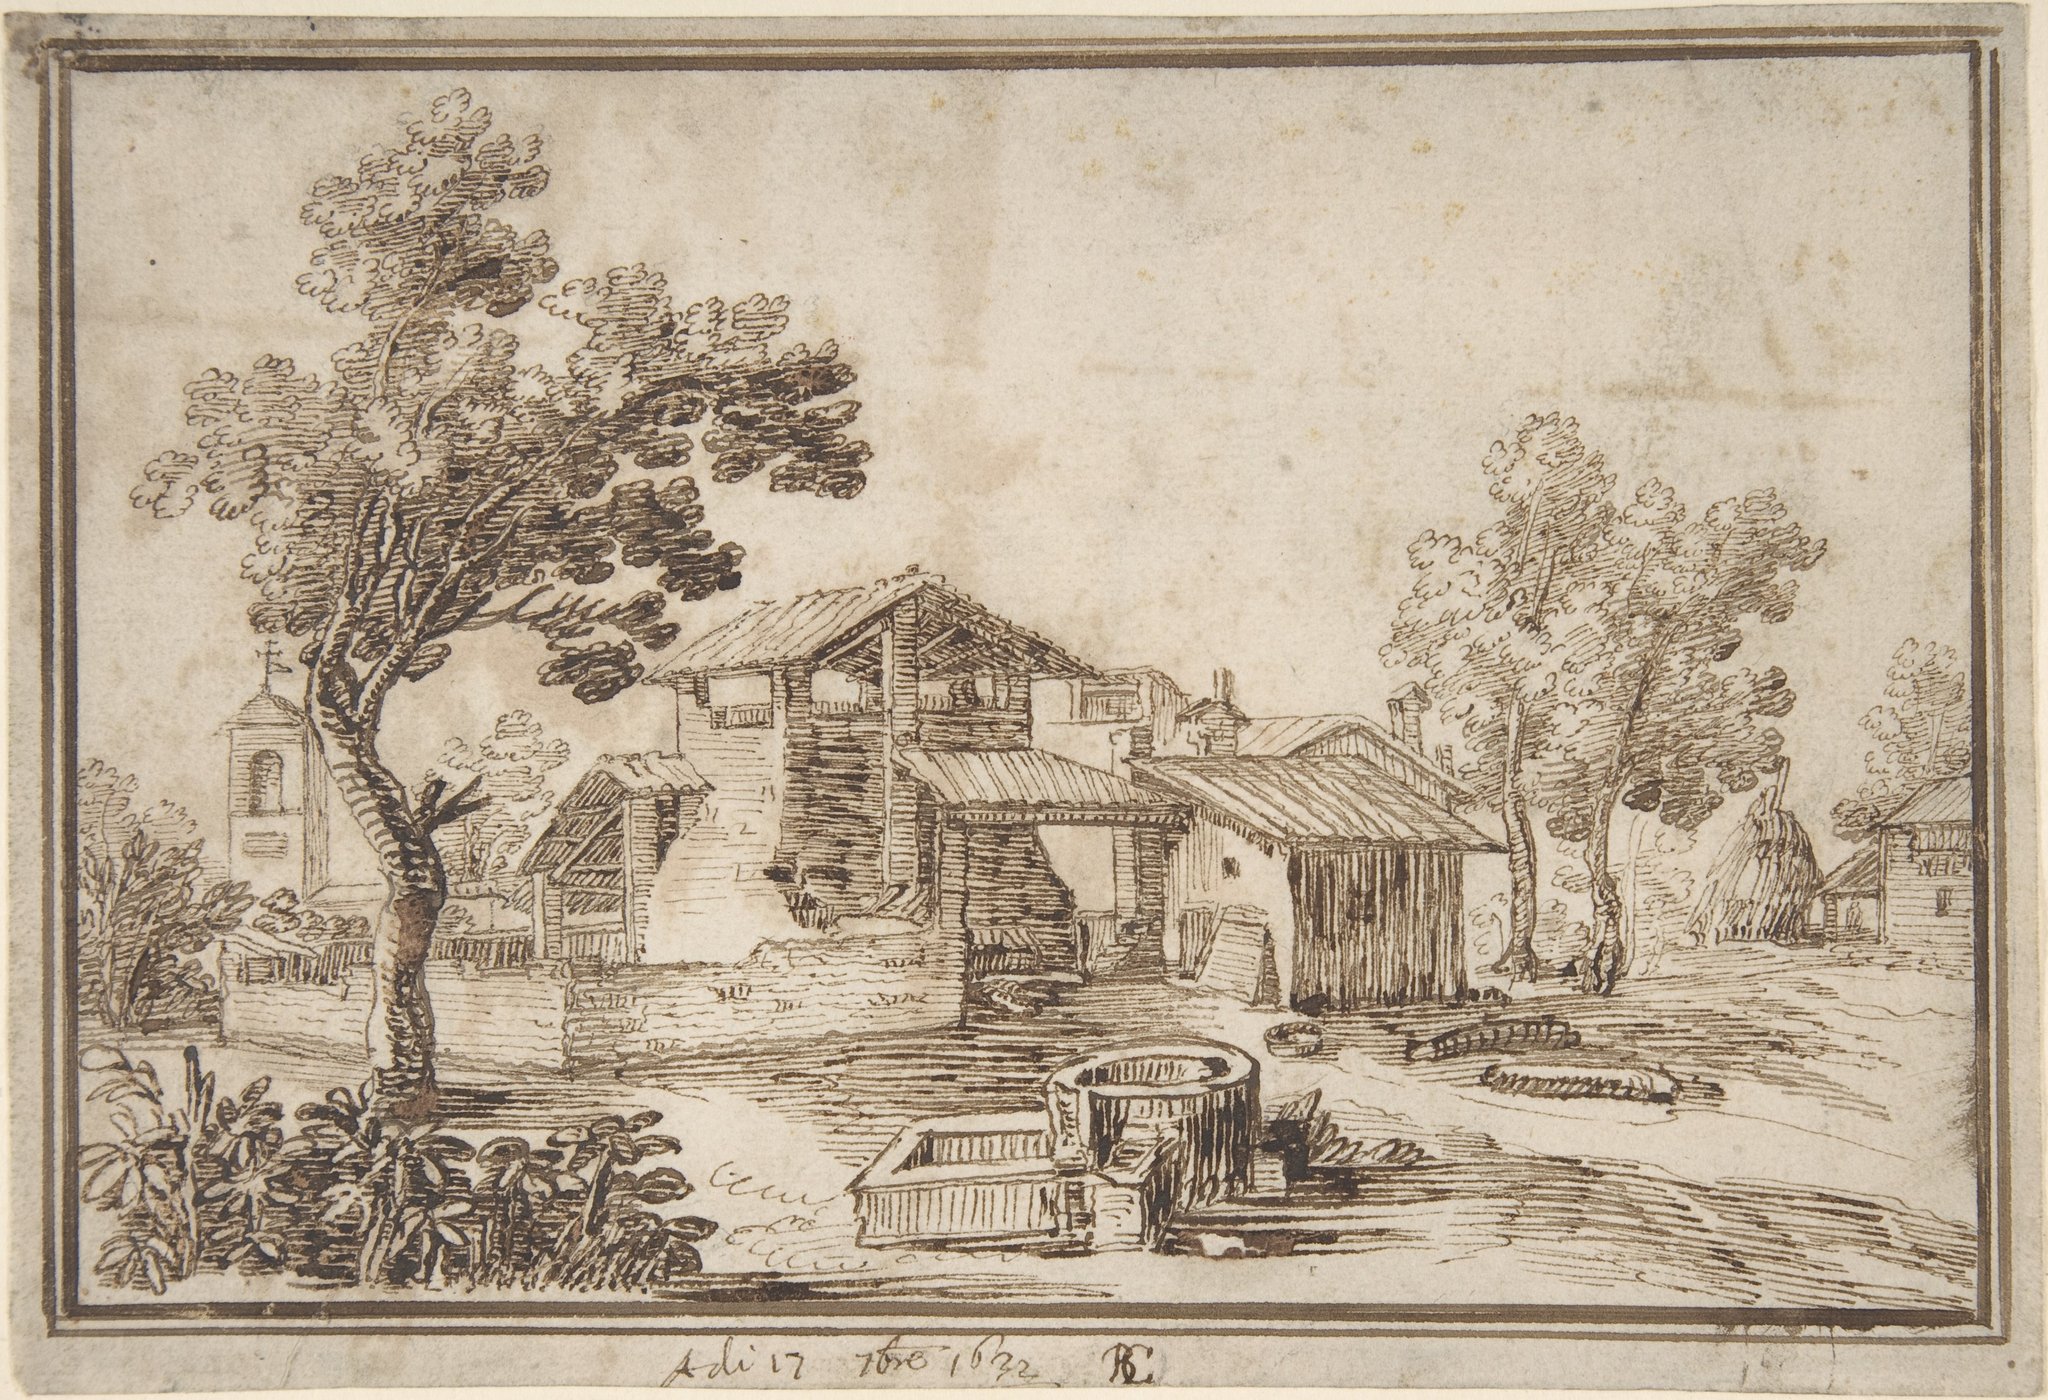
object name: drawing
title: Landscape with a Farm House and a Bell Tower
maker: remigio cantagallina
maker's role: artist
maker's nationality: italian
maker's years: 1582-1656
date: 1582-1656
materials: ink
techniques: pen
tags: musical instruments,houses,towers,landscapes,trees